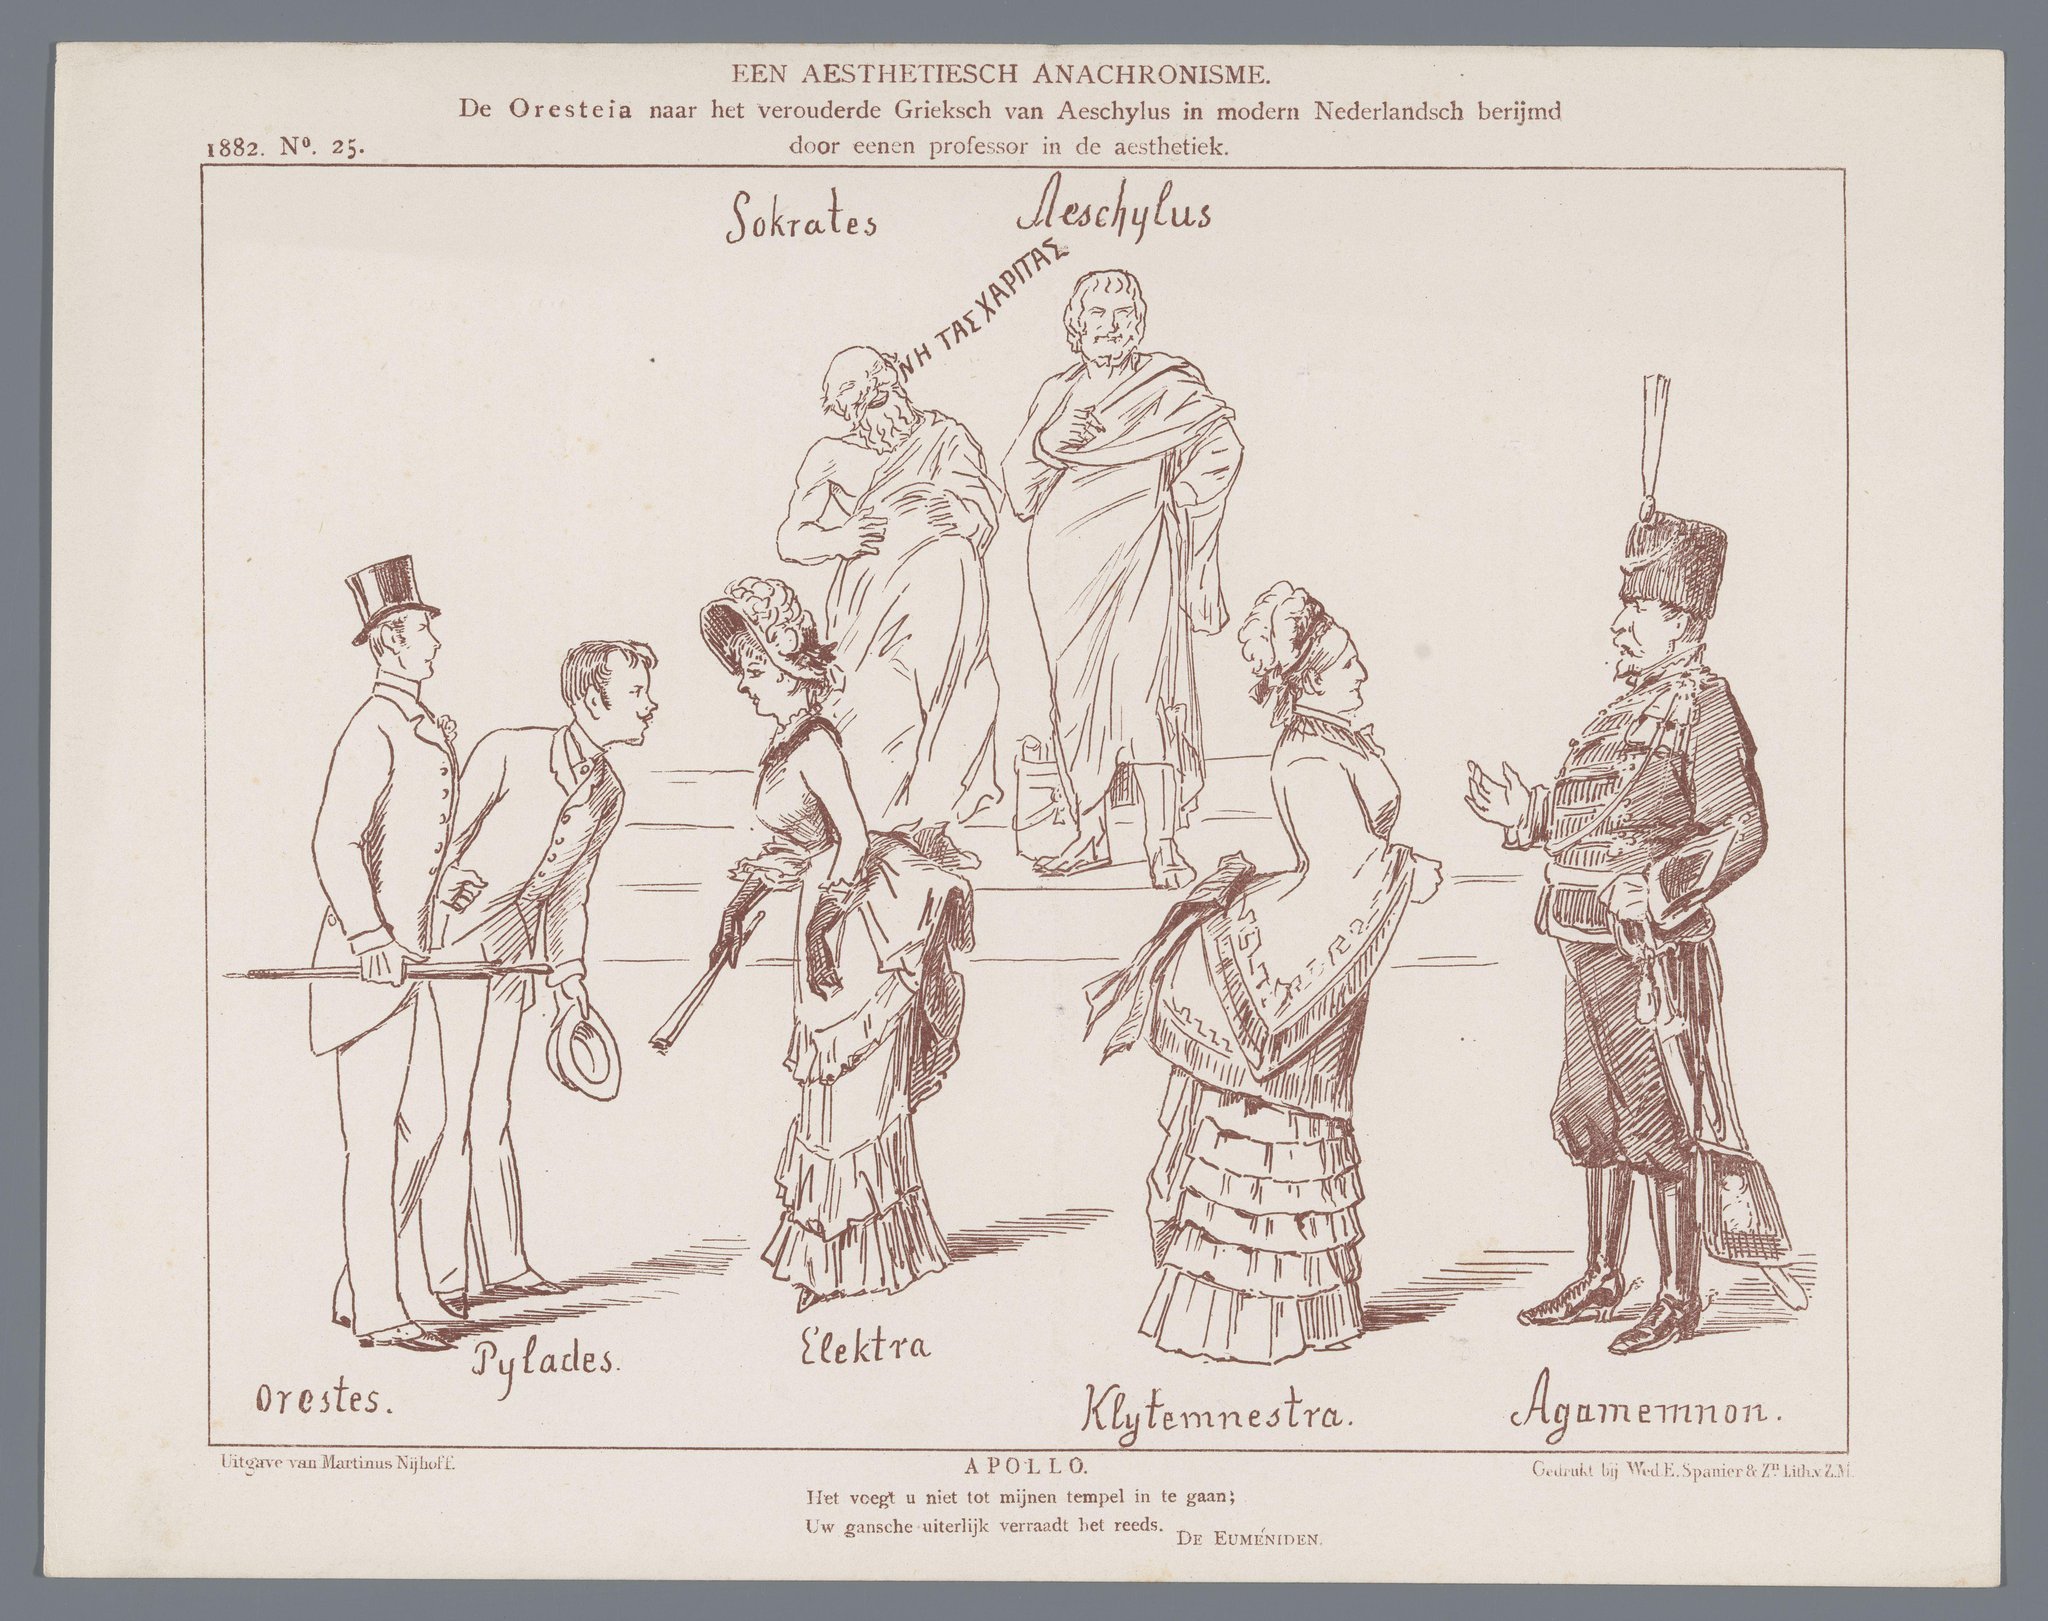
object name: print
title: Politieke spotprent, 1882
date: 1882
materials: paper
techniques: lithograph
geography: netherlands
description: Politieke spotprent. Plaat verschenen bij het weekblad De Nederlandsche Spectator, nr. 25, 1882.